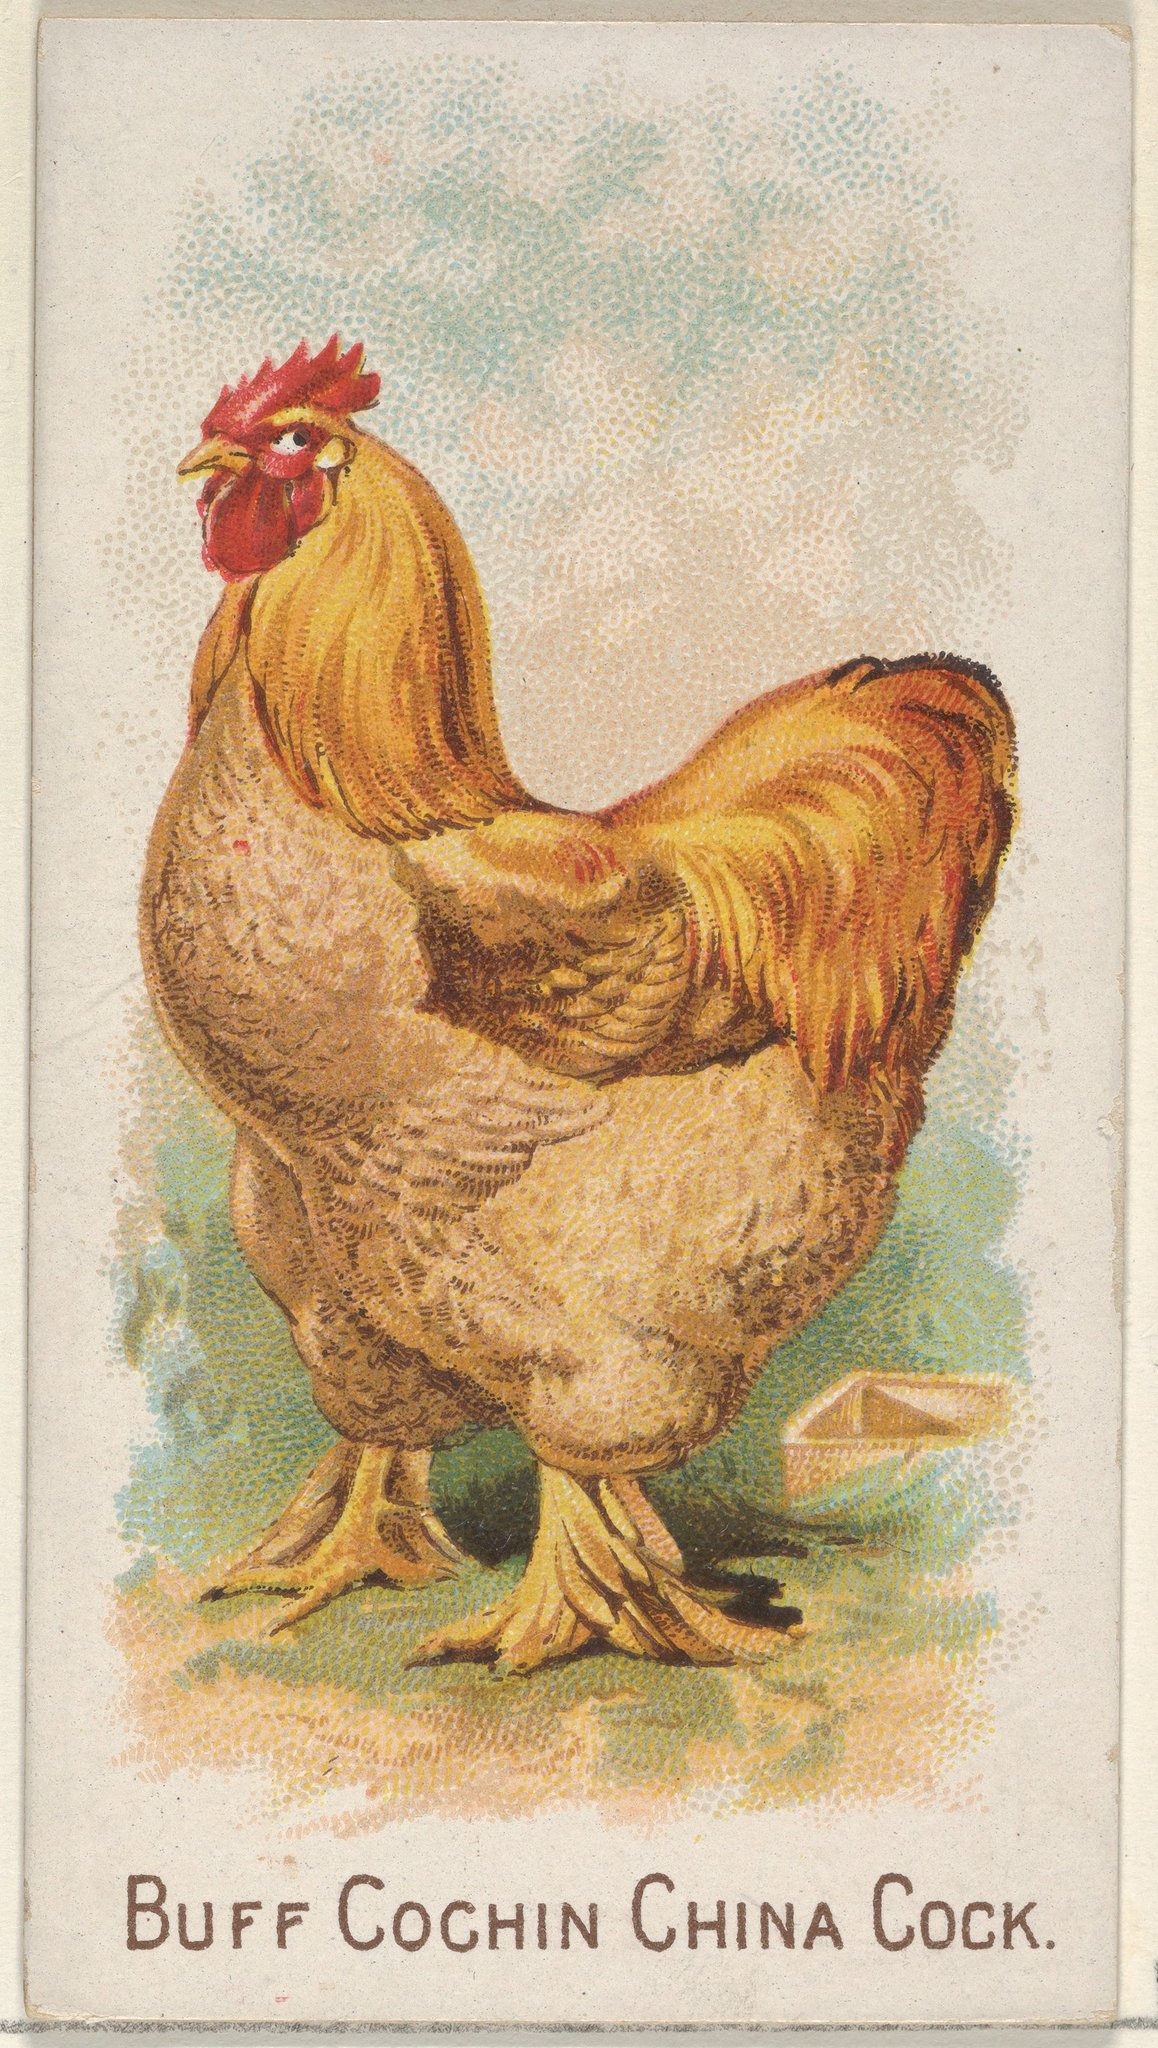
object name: print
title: Buff Cochin China Cock, from the Prize and Game Chickens series (N20) for Allen & Ginter Cigarettes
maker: allen & ginter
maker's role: publisher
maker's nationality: american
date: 1891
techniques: color lithograph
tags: roosters